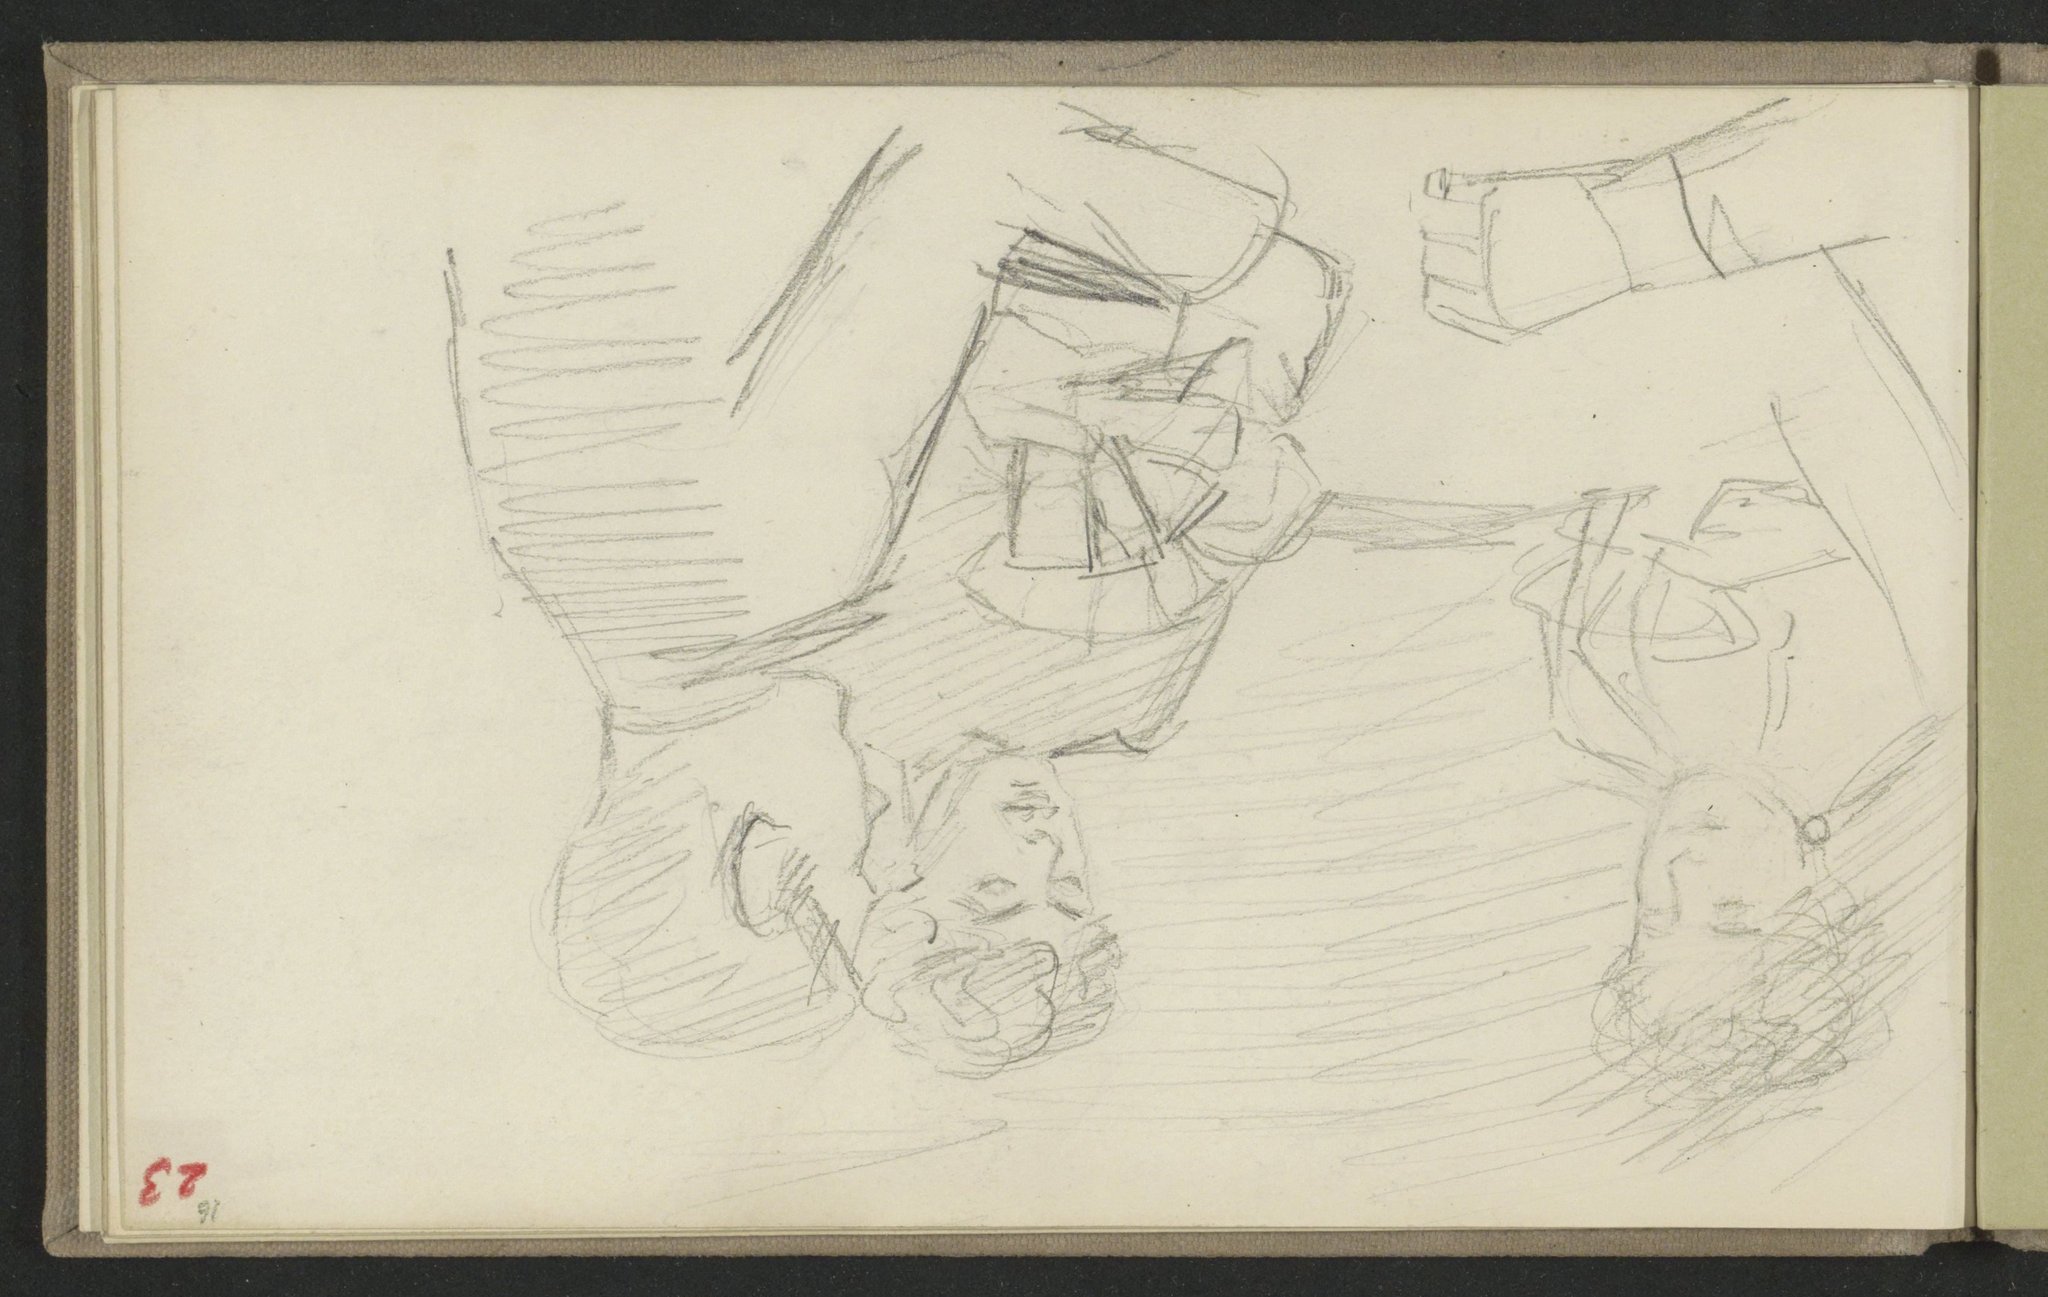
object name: sketchbook leaf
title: Vier kaartspelers rondom een tafel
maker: jozef israëls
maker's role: draughtsman, painter, print maker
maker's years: 1824-1911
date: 1834-1911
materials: paper, pencil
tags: playing-cards (+ sportsman, player, etc.)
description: Blad 10 verso uit een schetsboek met 26 bladen.